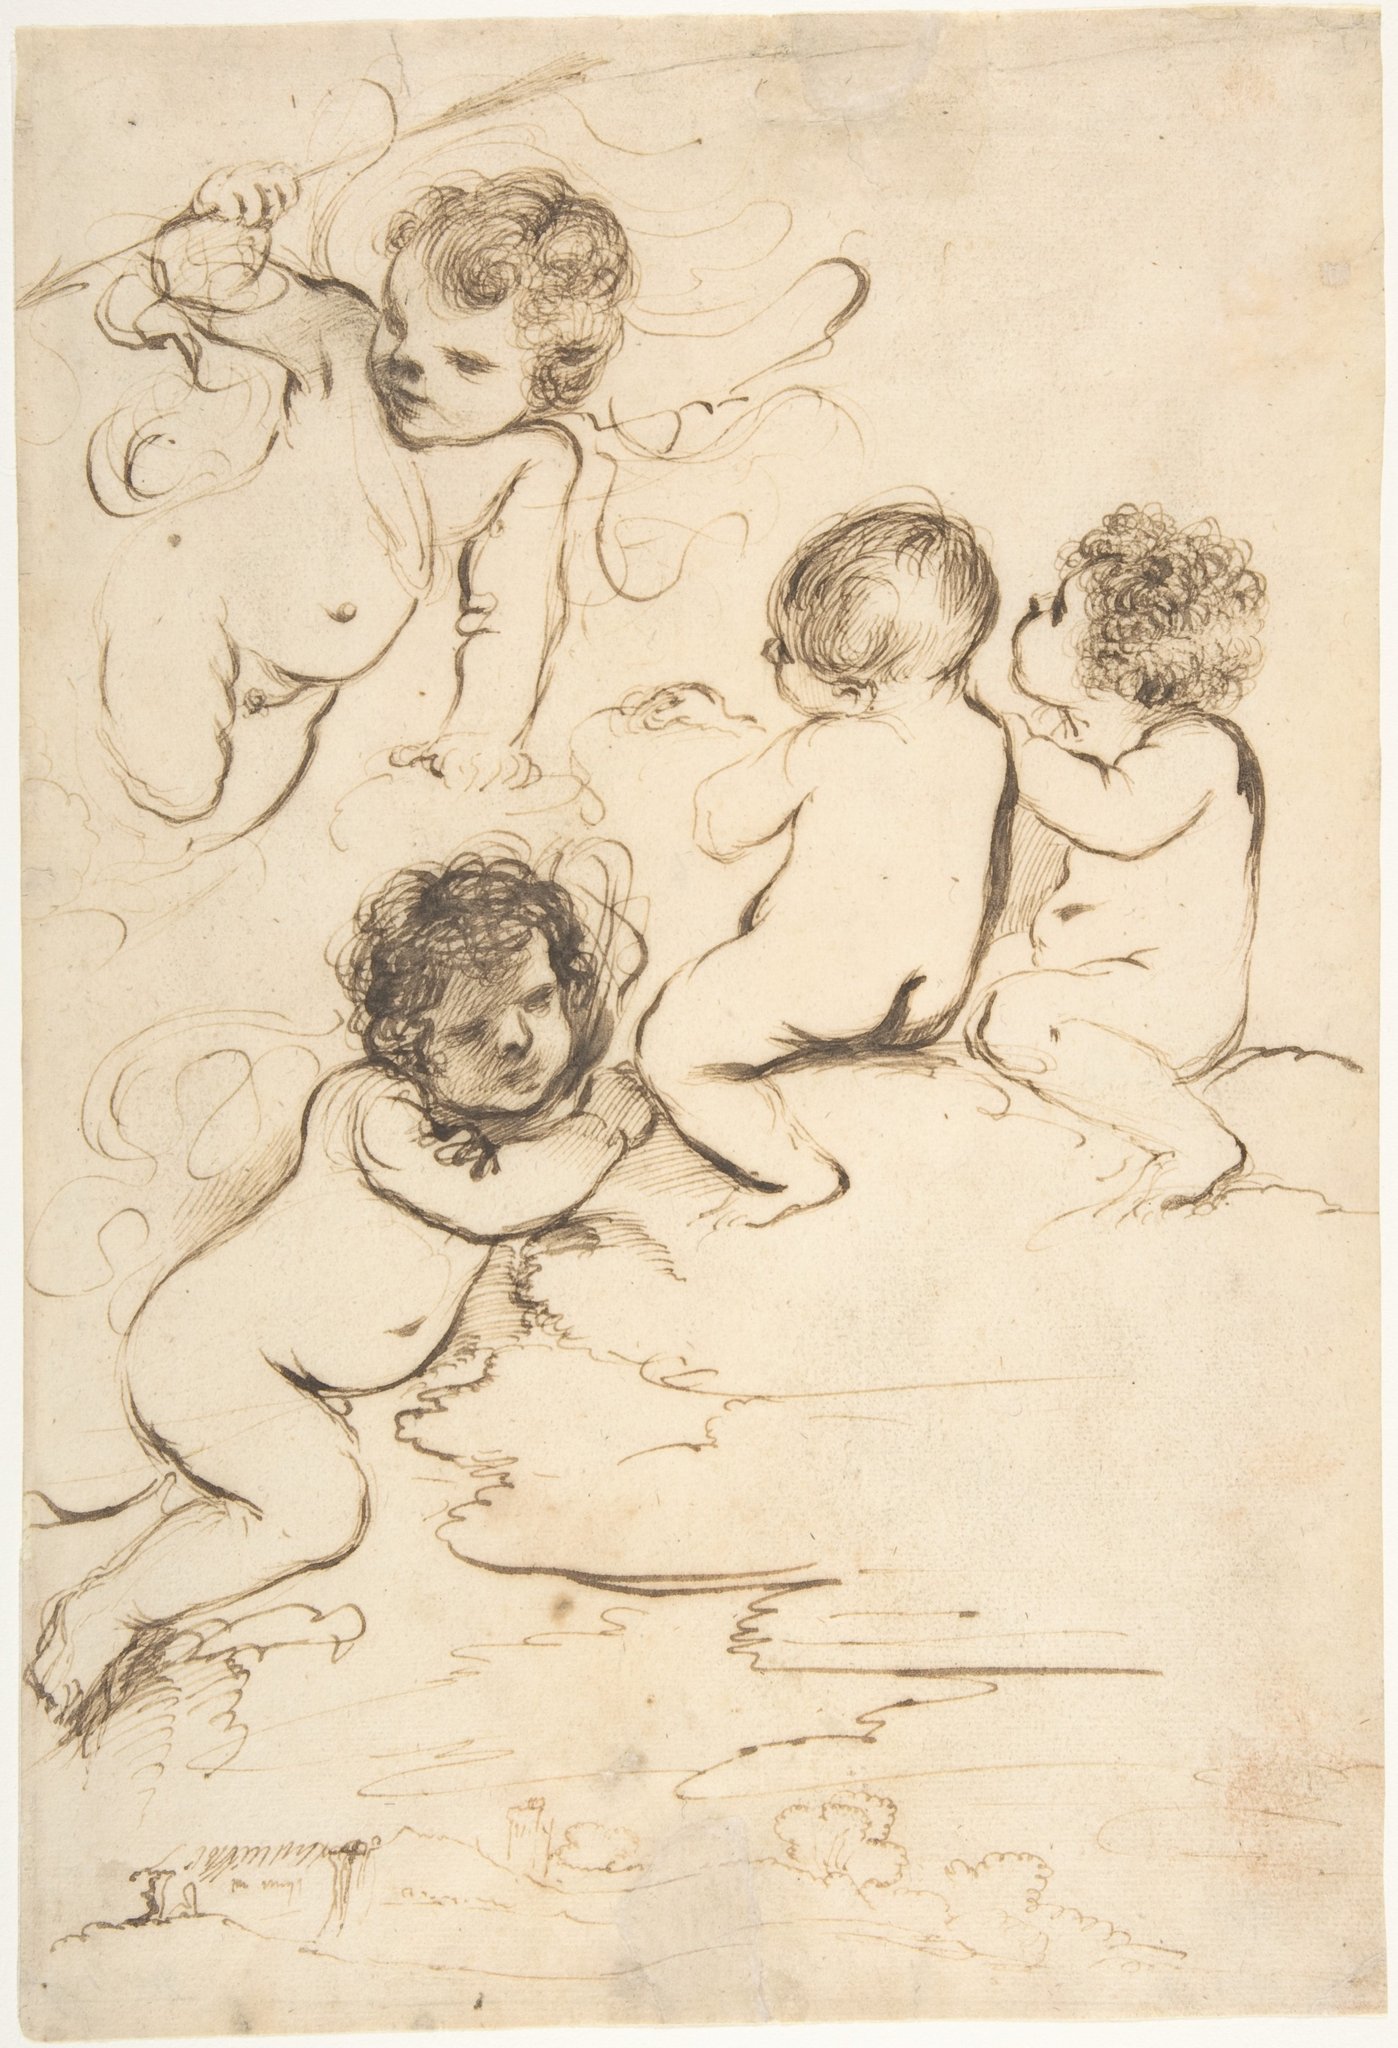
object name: drawing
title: Four Putti with Bow and Arrows on Clouds above a Landscape with a Tower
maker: guercino (giovanni francesco barbieri)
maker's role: artist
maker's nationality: italian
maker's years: 1591-1666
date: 1591-1666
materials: chalk, ink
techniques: brush, pen, wash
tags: putti